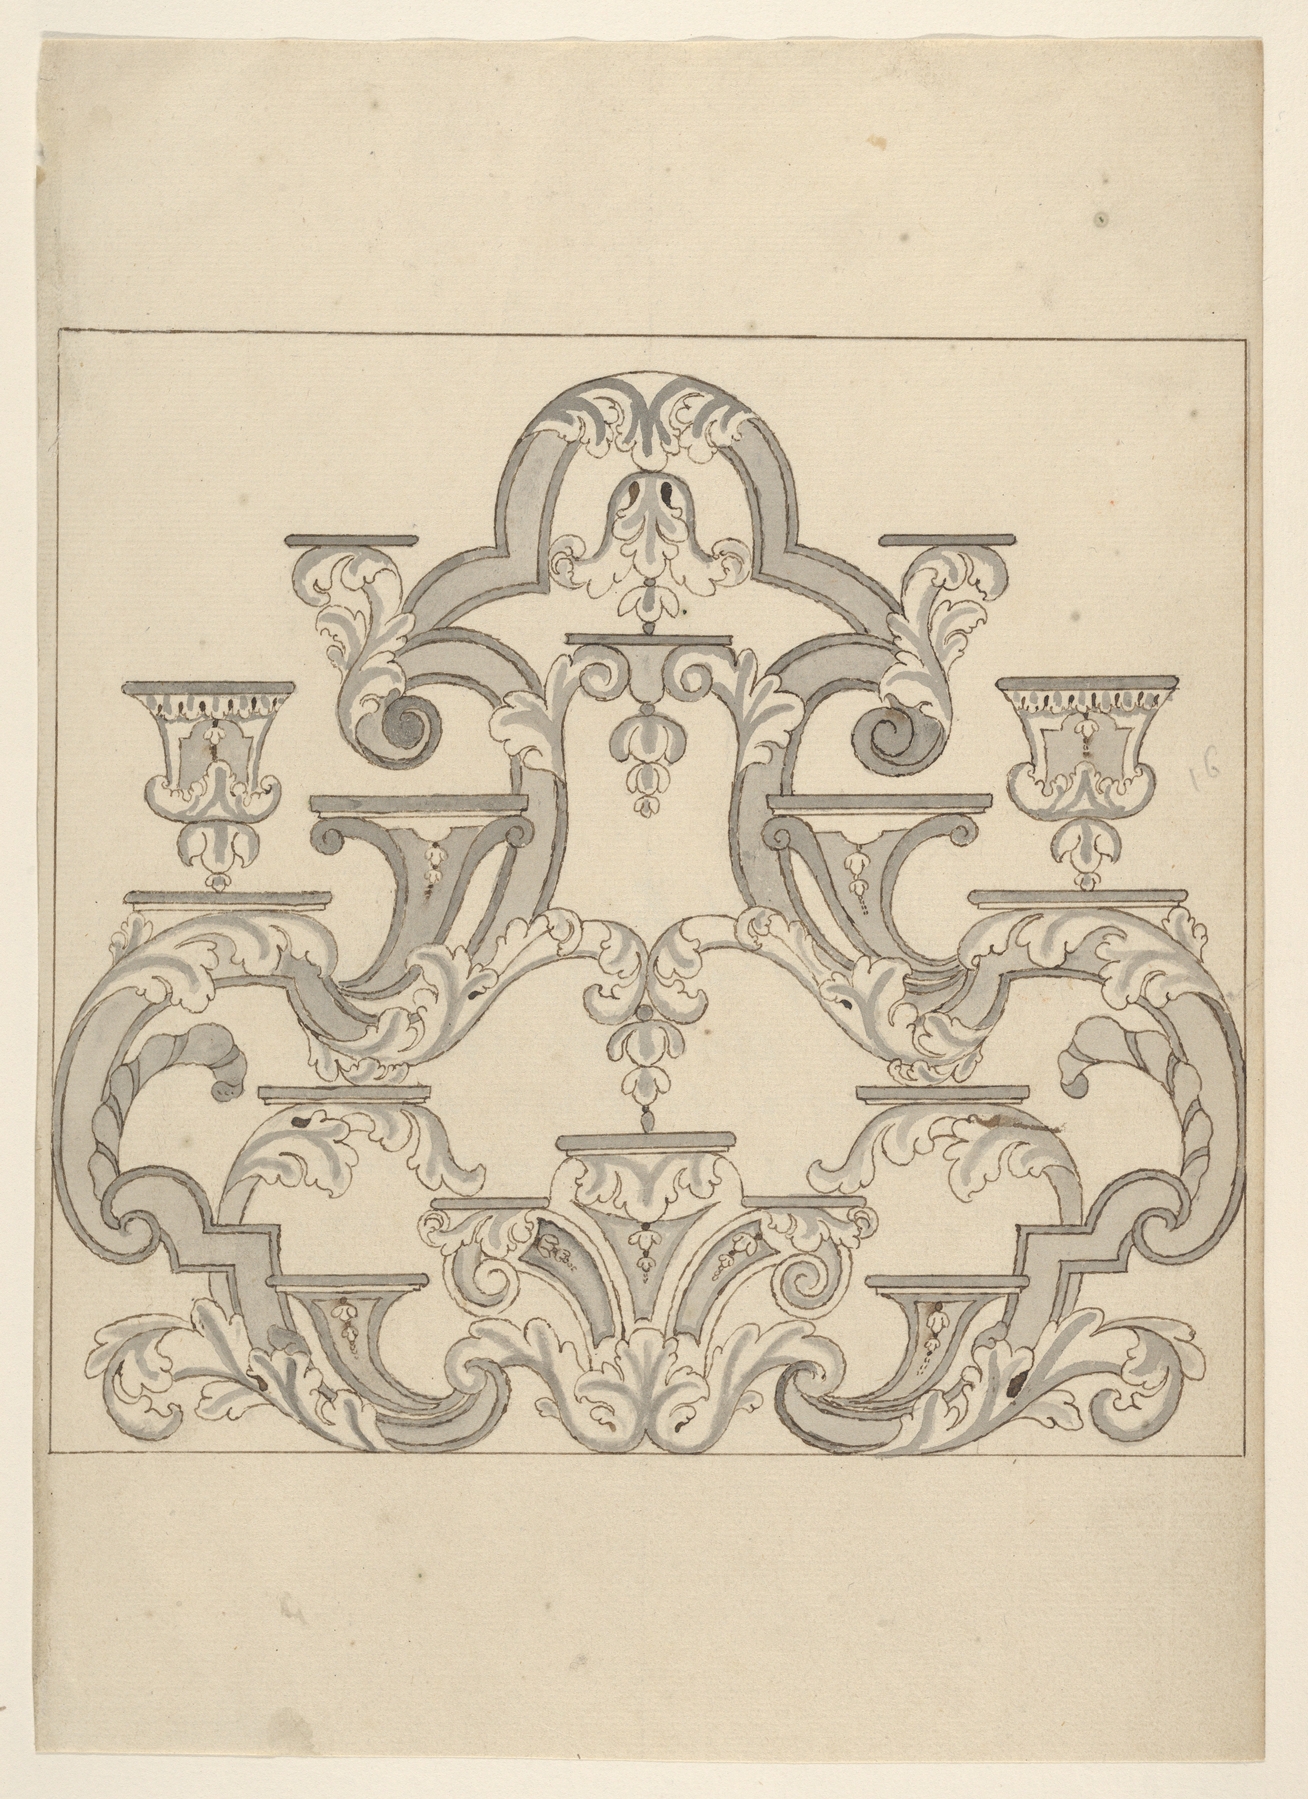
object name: drawing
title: Design for a Shelf System to Display Porcelain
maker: anonymous, 18th century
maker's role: artist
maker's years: 1700-1800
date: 1700-1730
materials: ink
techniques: pen, wash